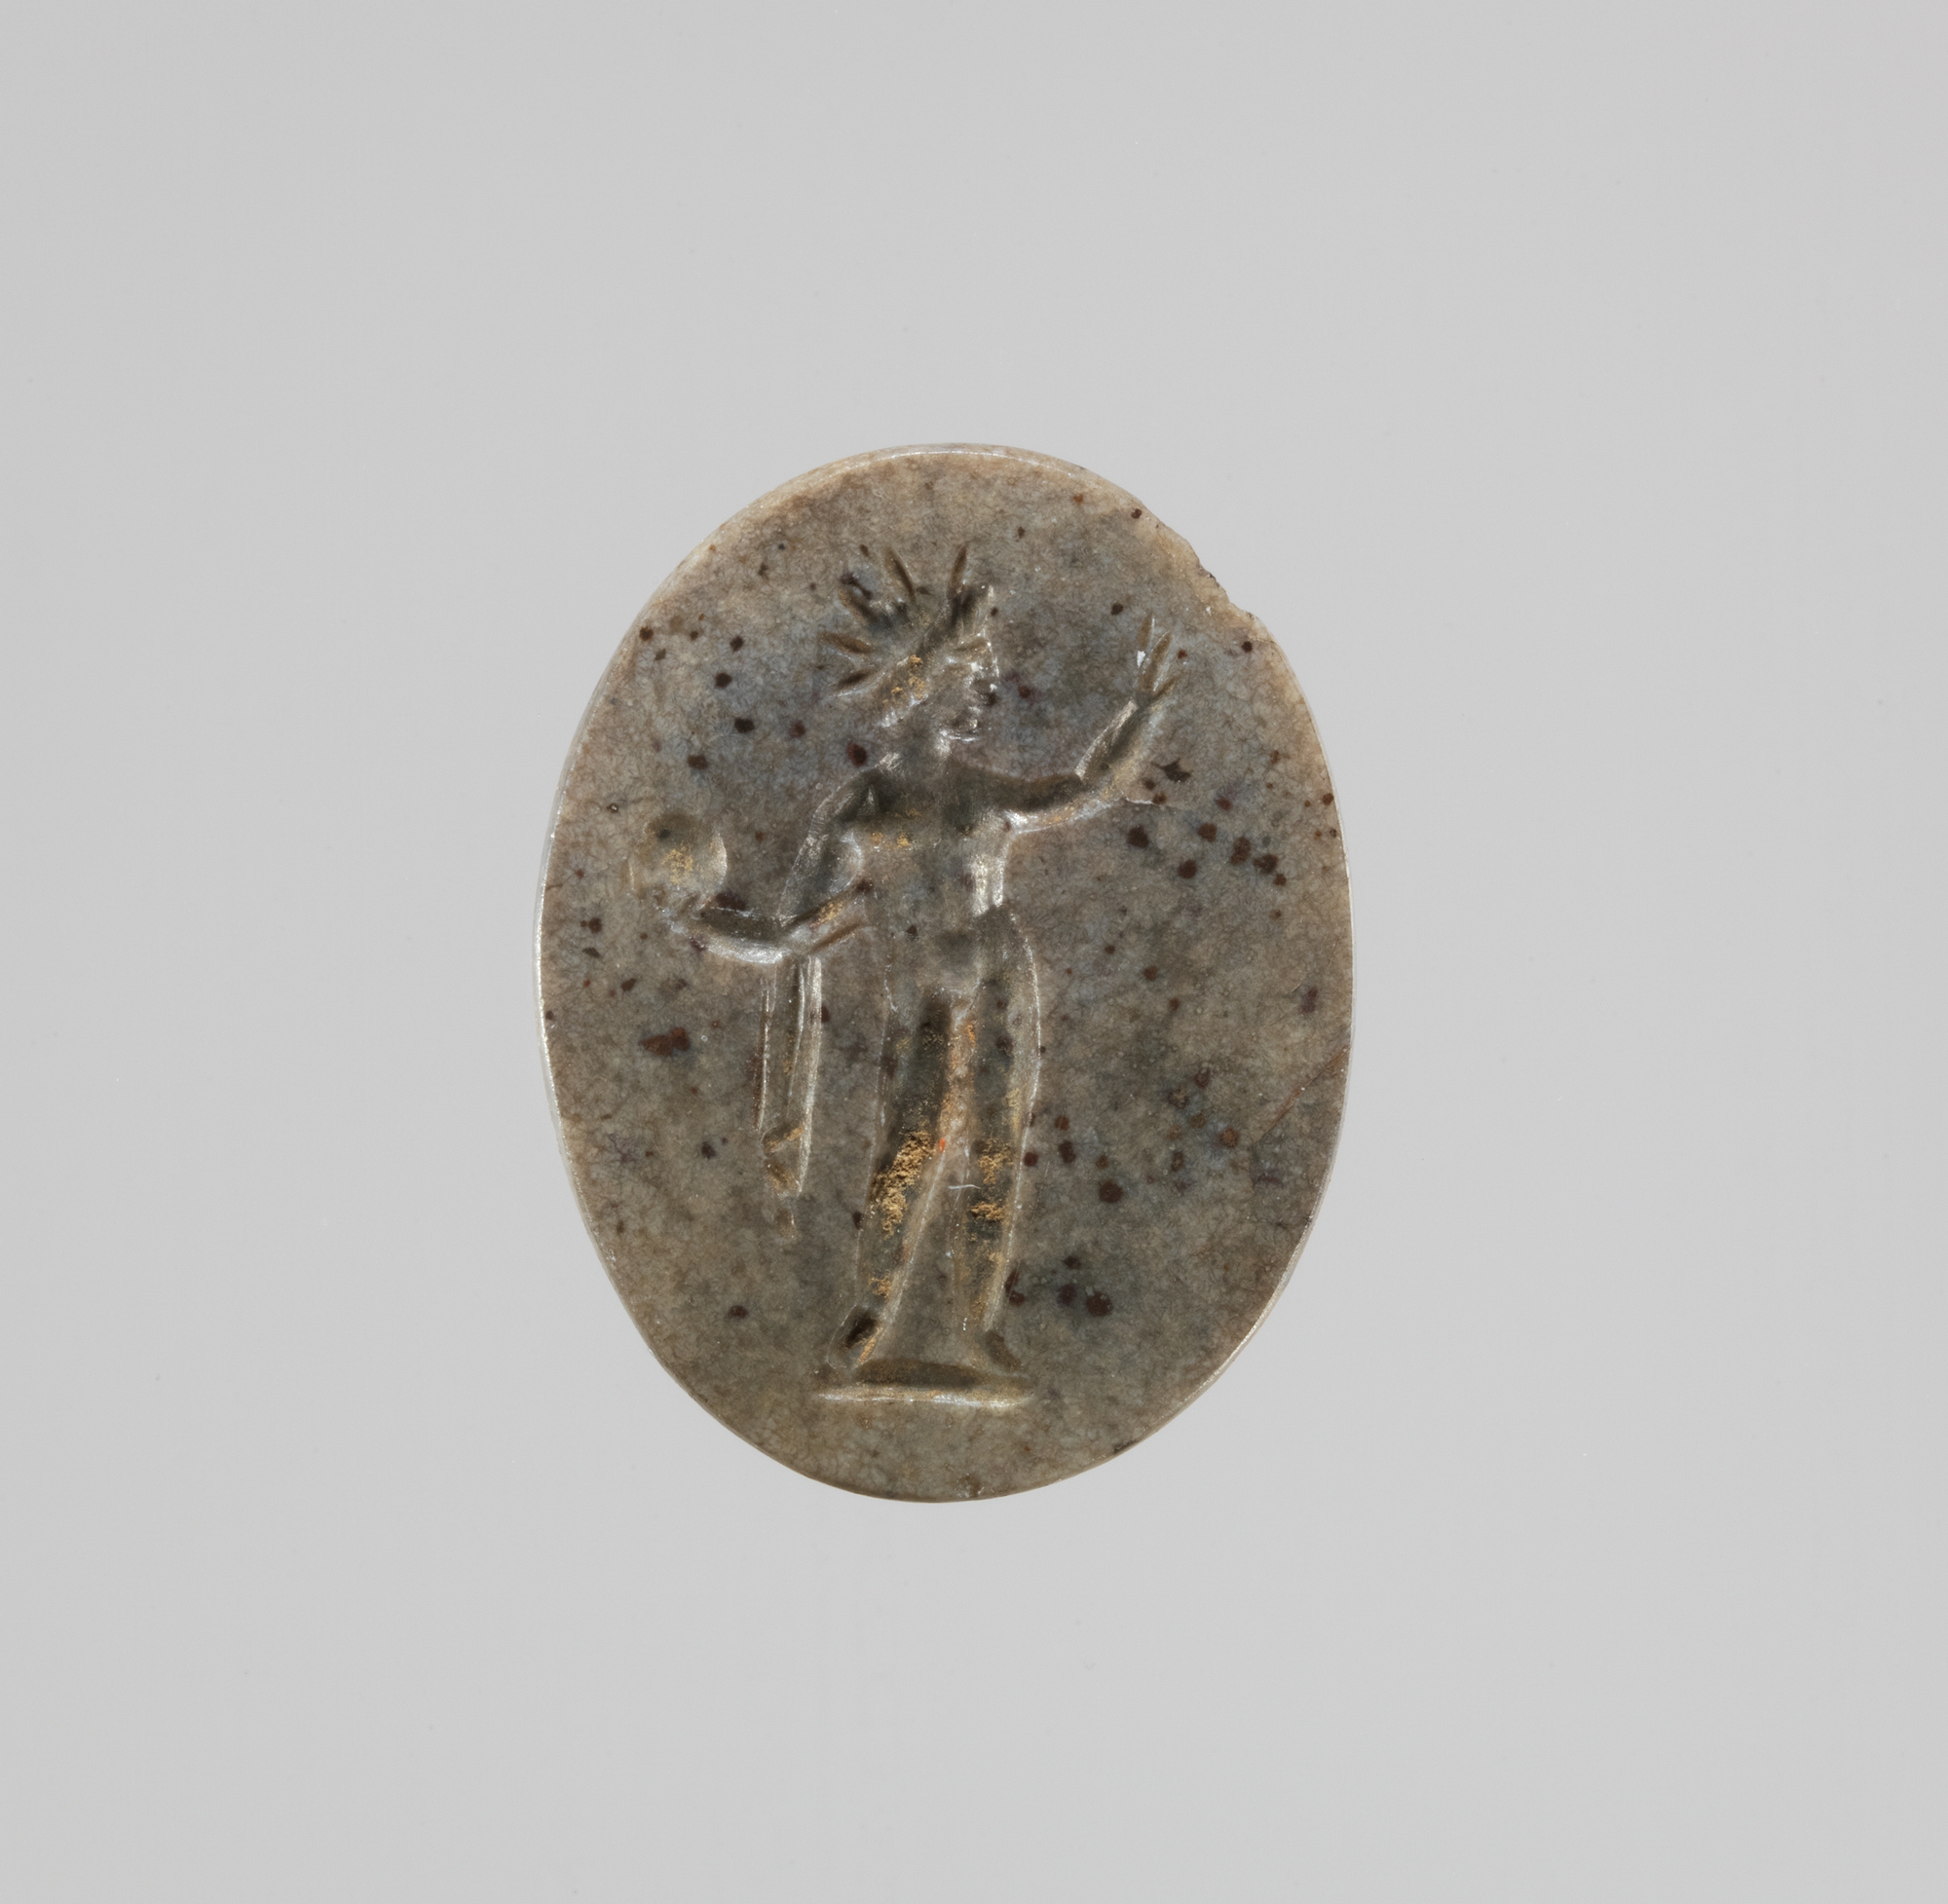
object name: intaglio, magical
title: Hematite intaglio: Standing deity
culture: roman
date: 31-330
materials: mineral